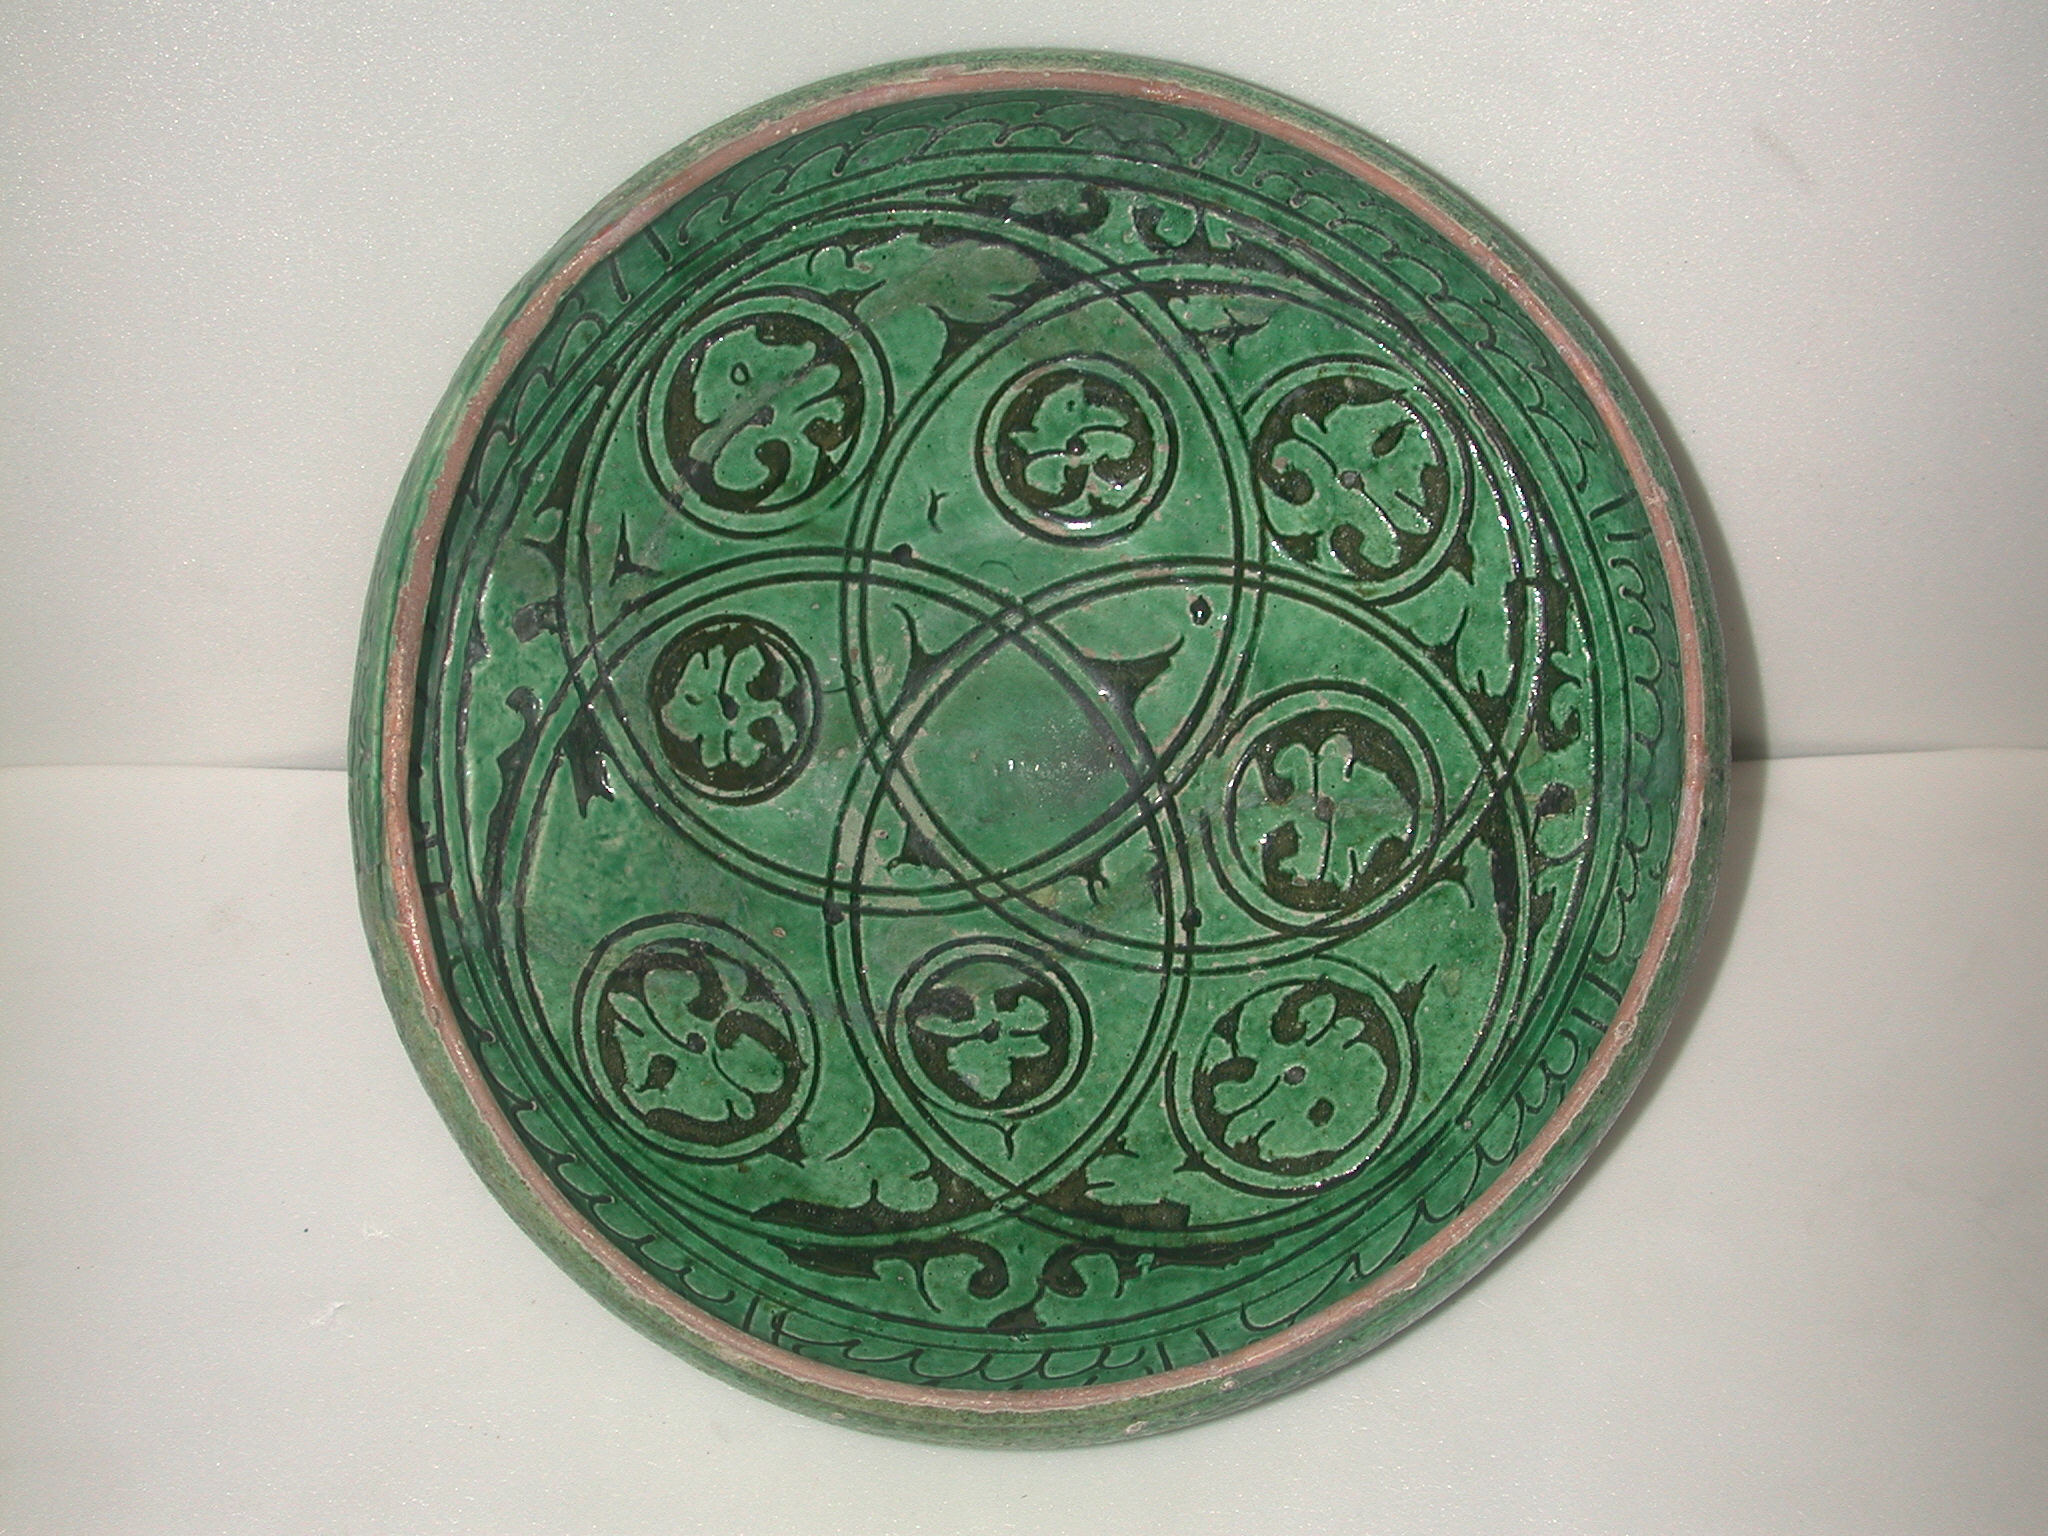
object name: bowl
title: Garrus-Ware Bowl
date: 1101-1300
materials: earthenware, glaze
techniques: carving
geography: iran